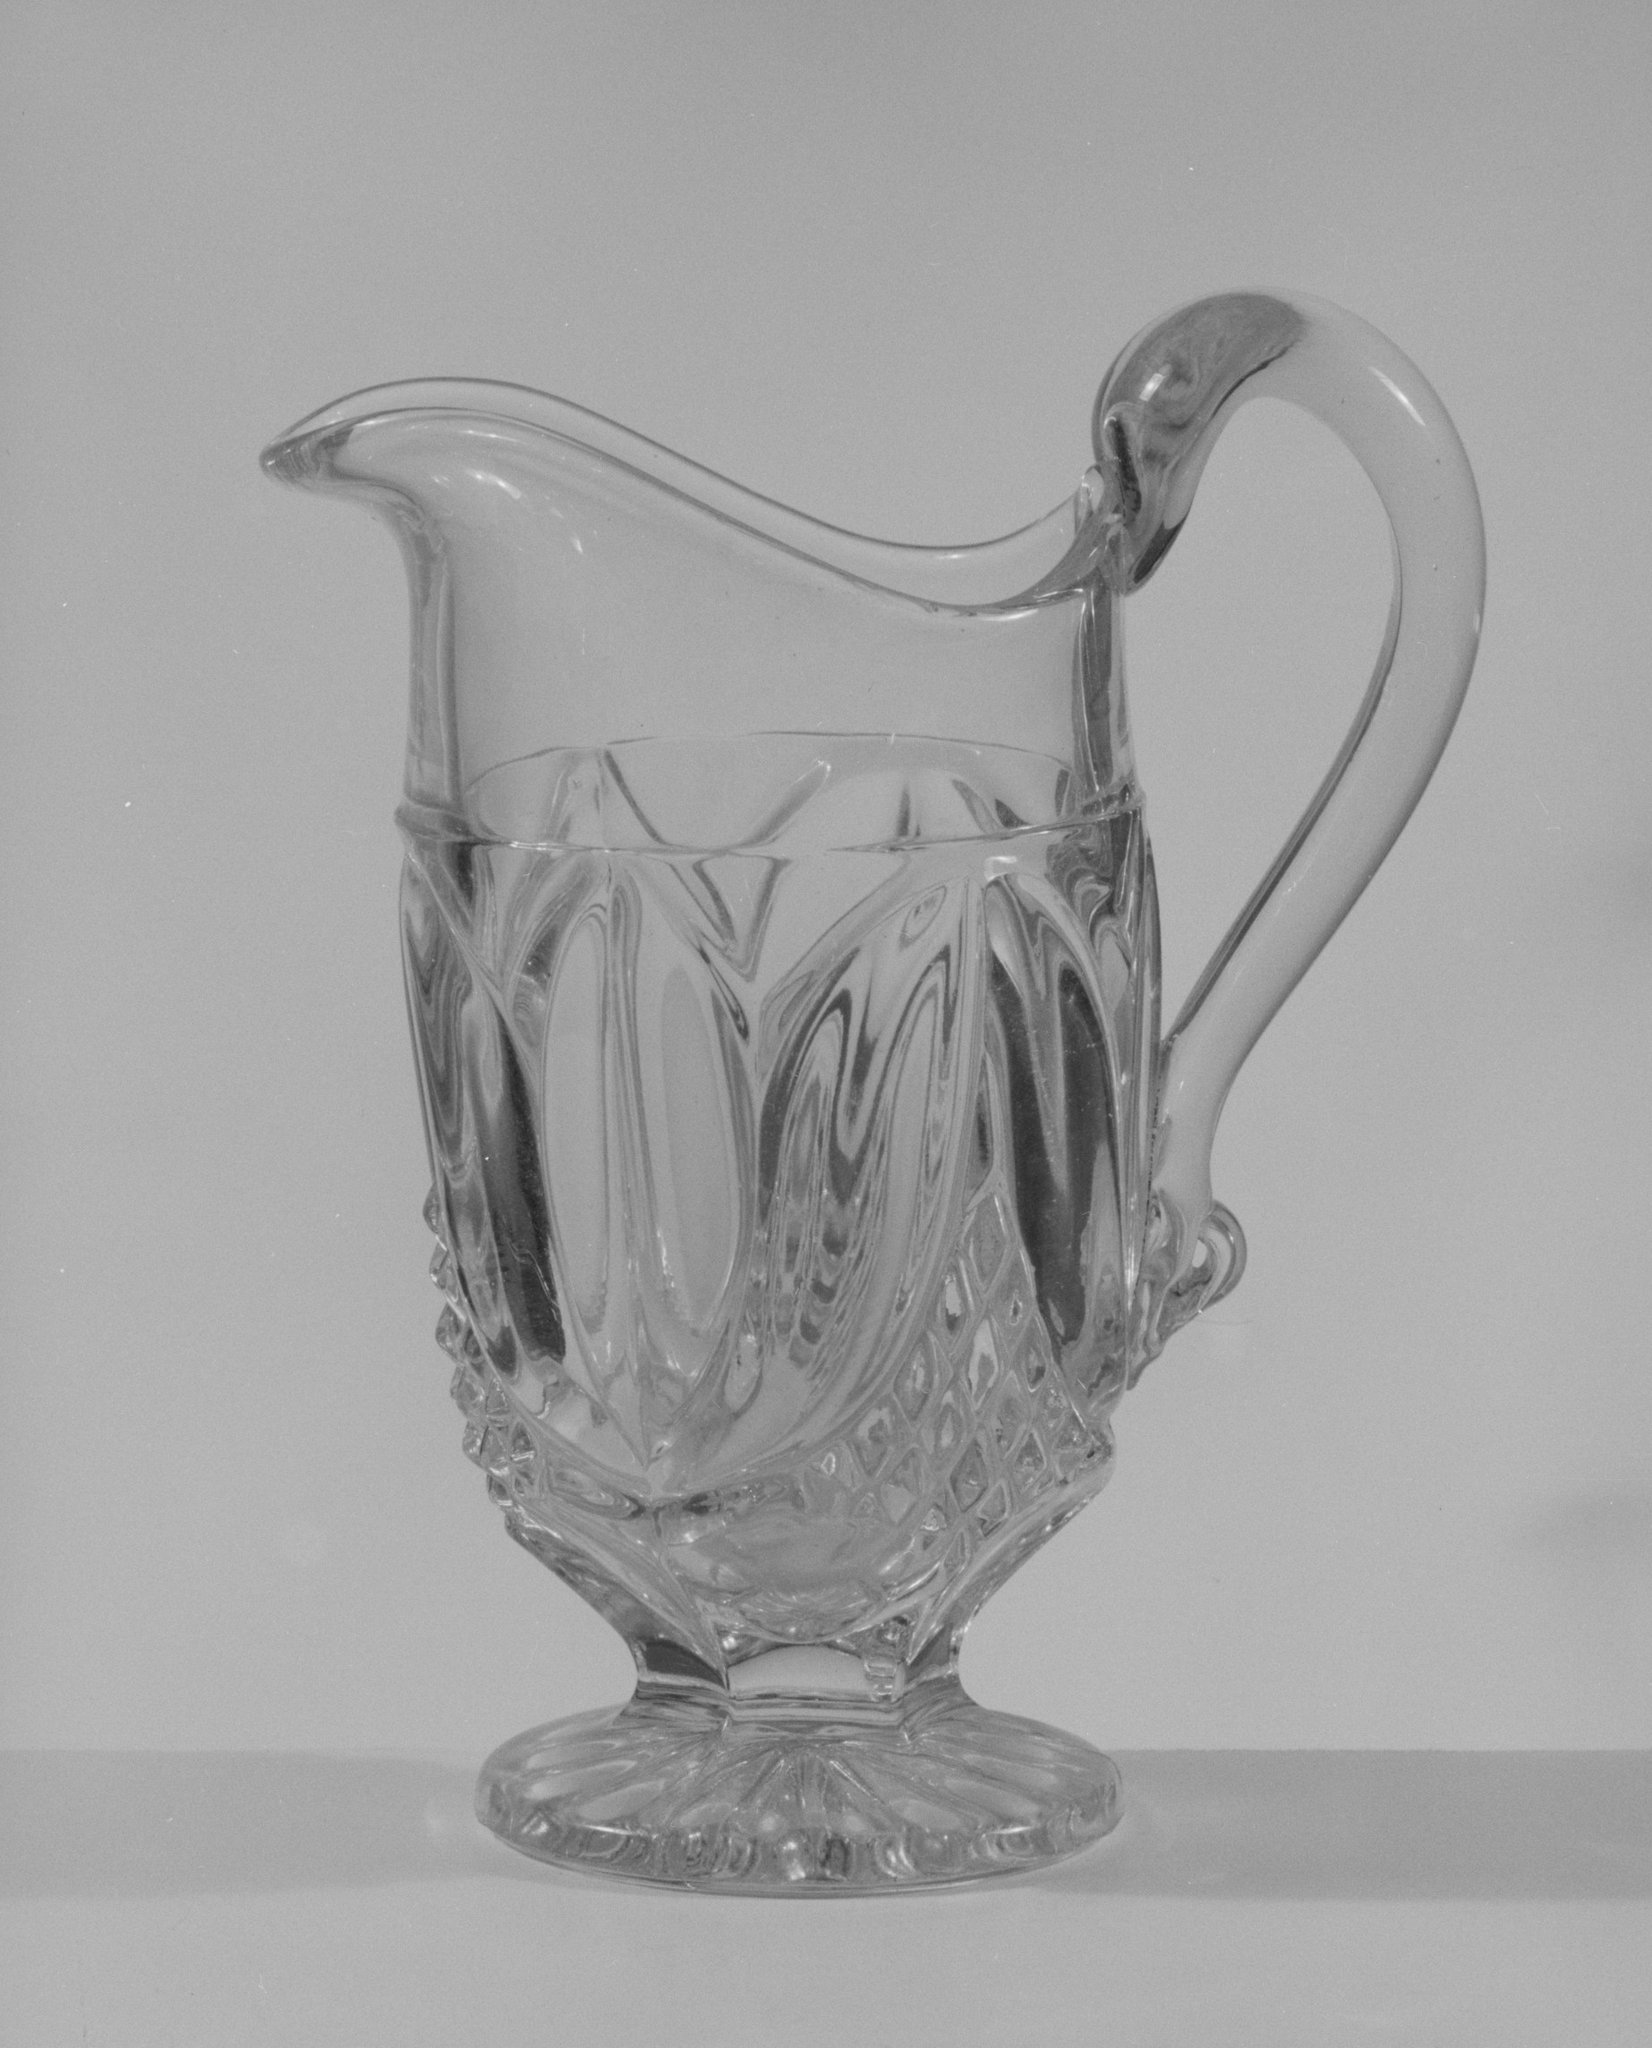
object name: pitcher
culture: american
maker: bryce, walker and company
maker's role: maker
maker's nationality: american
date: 1860-1870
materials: glass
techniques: pressed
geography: united states